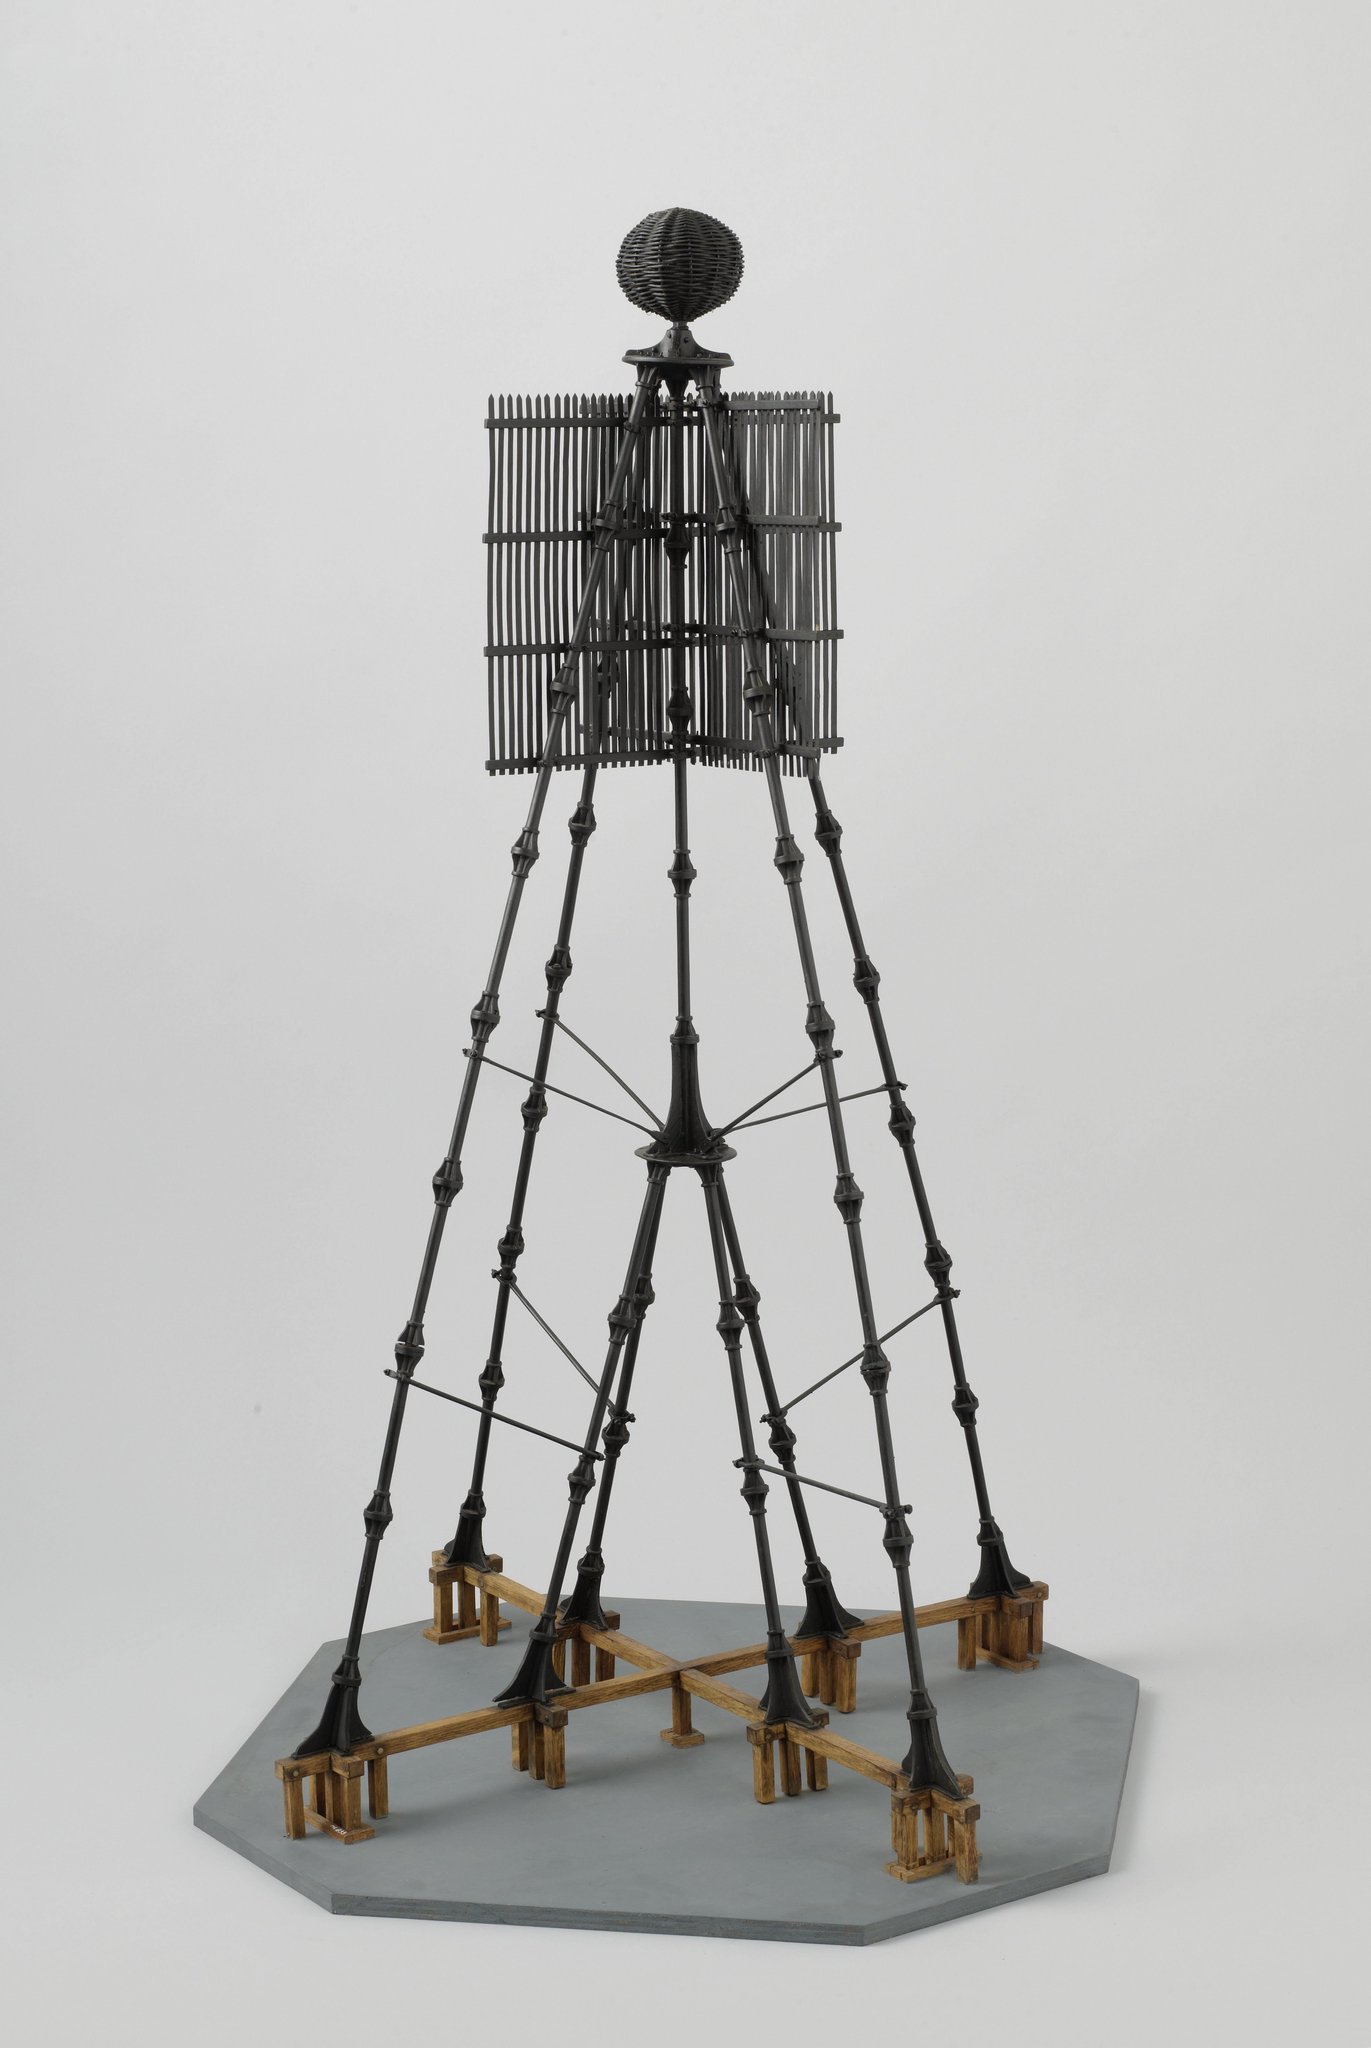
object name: demonstration model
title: Model of a Land Beacon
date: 1850-1855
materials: paint, wood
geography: den helder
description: De oude houten kustkapen werden in de eerste helft van de negentiende eeuw door ijzeren vervangen.